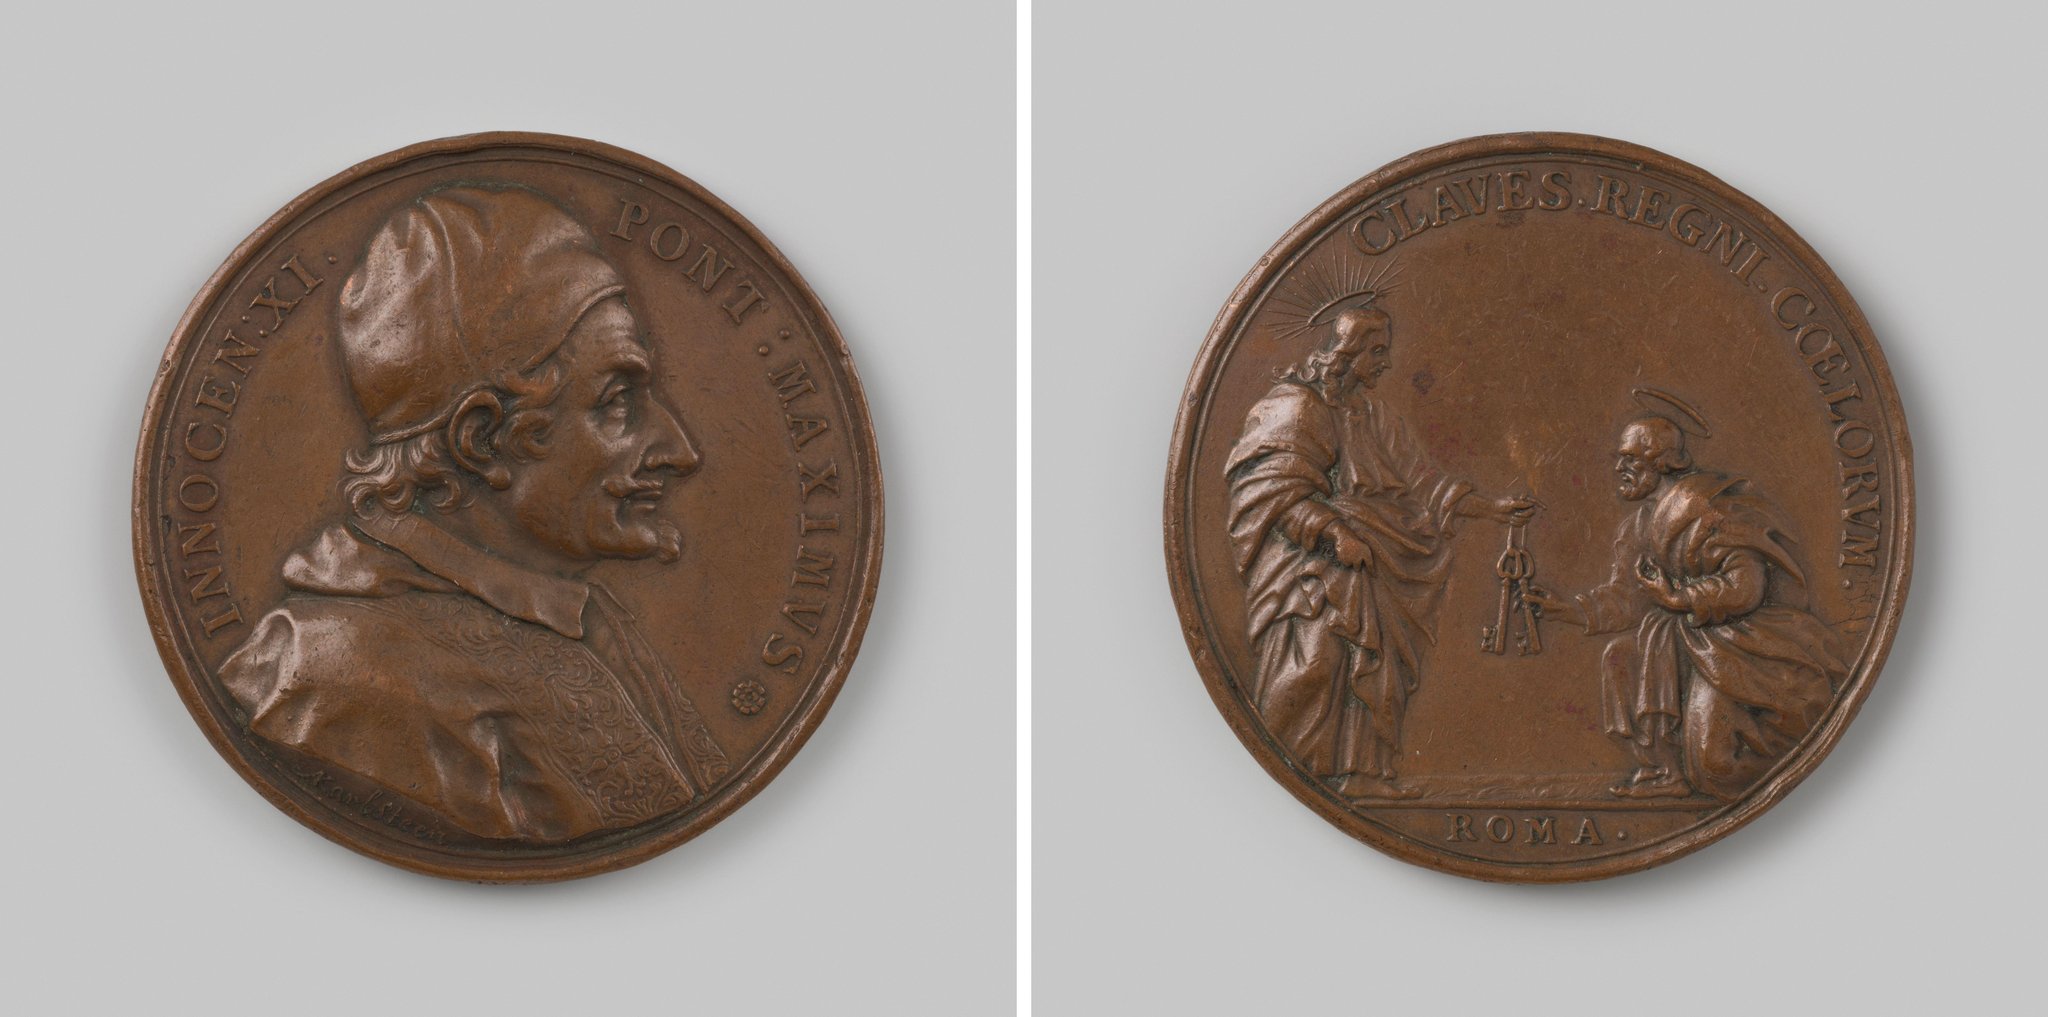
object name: history medal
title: Aantreden van Paus Innocentius XI 1676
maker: arvid karlsteen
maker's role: medailleur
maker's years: 1647-1718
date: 1676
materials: copper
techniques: striking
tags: christ gives the keys of heaven to peter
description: Koperen penning, op de voorzijde het borstbeeld van Innocentius naar rechts met omschrift, op de keerzijde Christus die de knielende Petrus de sleutels van de hemel overhandigt, met omschrift en afsnedetekst.